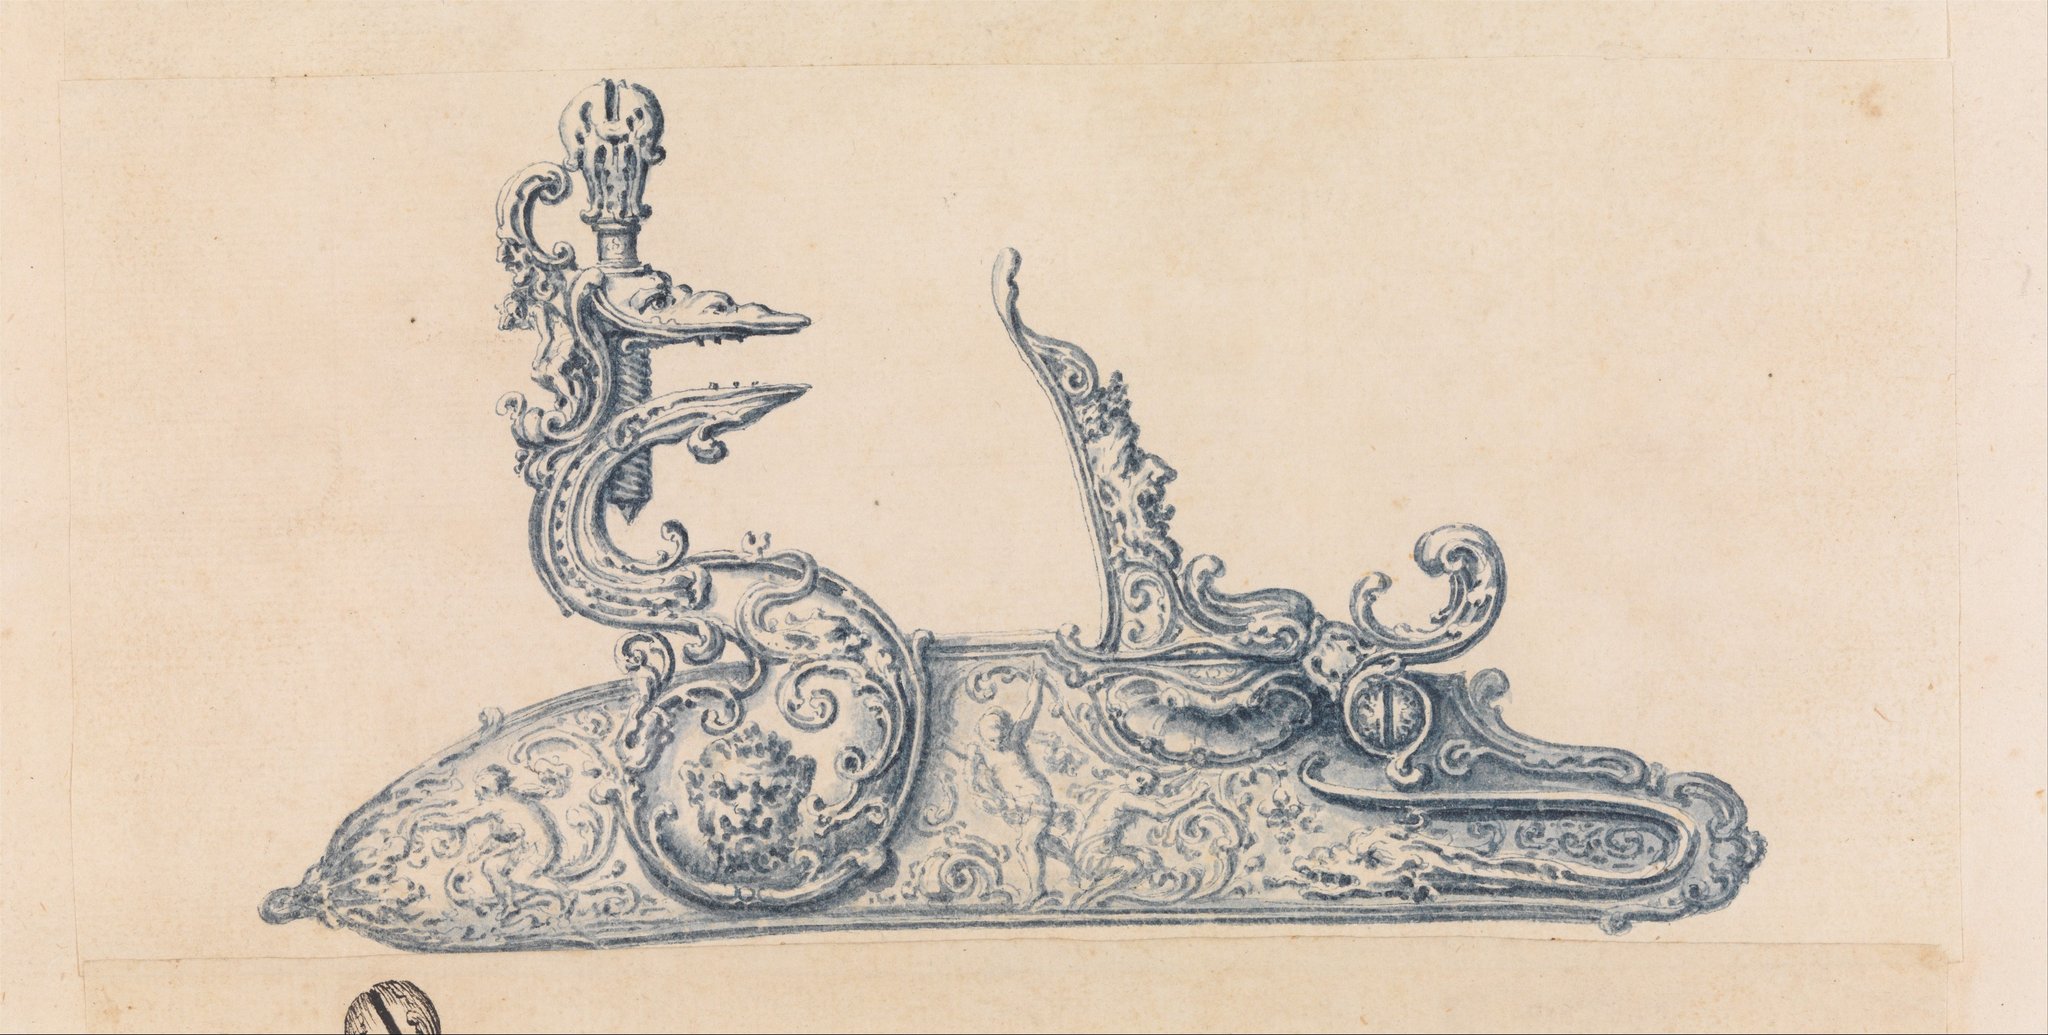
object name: drawing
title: Drawing from an Ornament Scrapbook: A Flintlock Gun Lock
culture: french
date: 1701-1800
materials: ink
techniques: pen, wash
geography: france